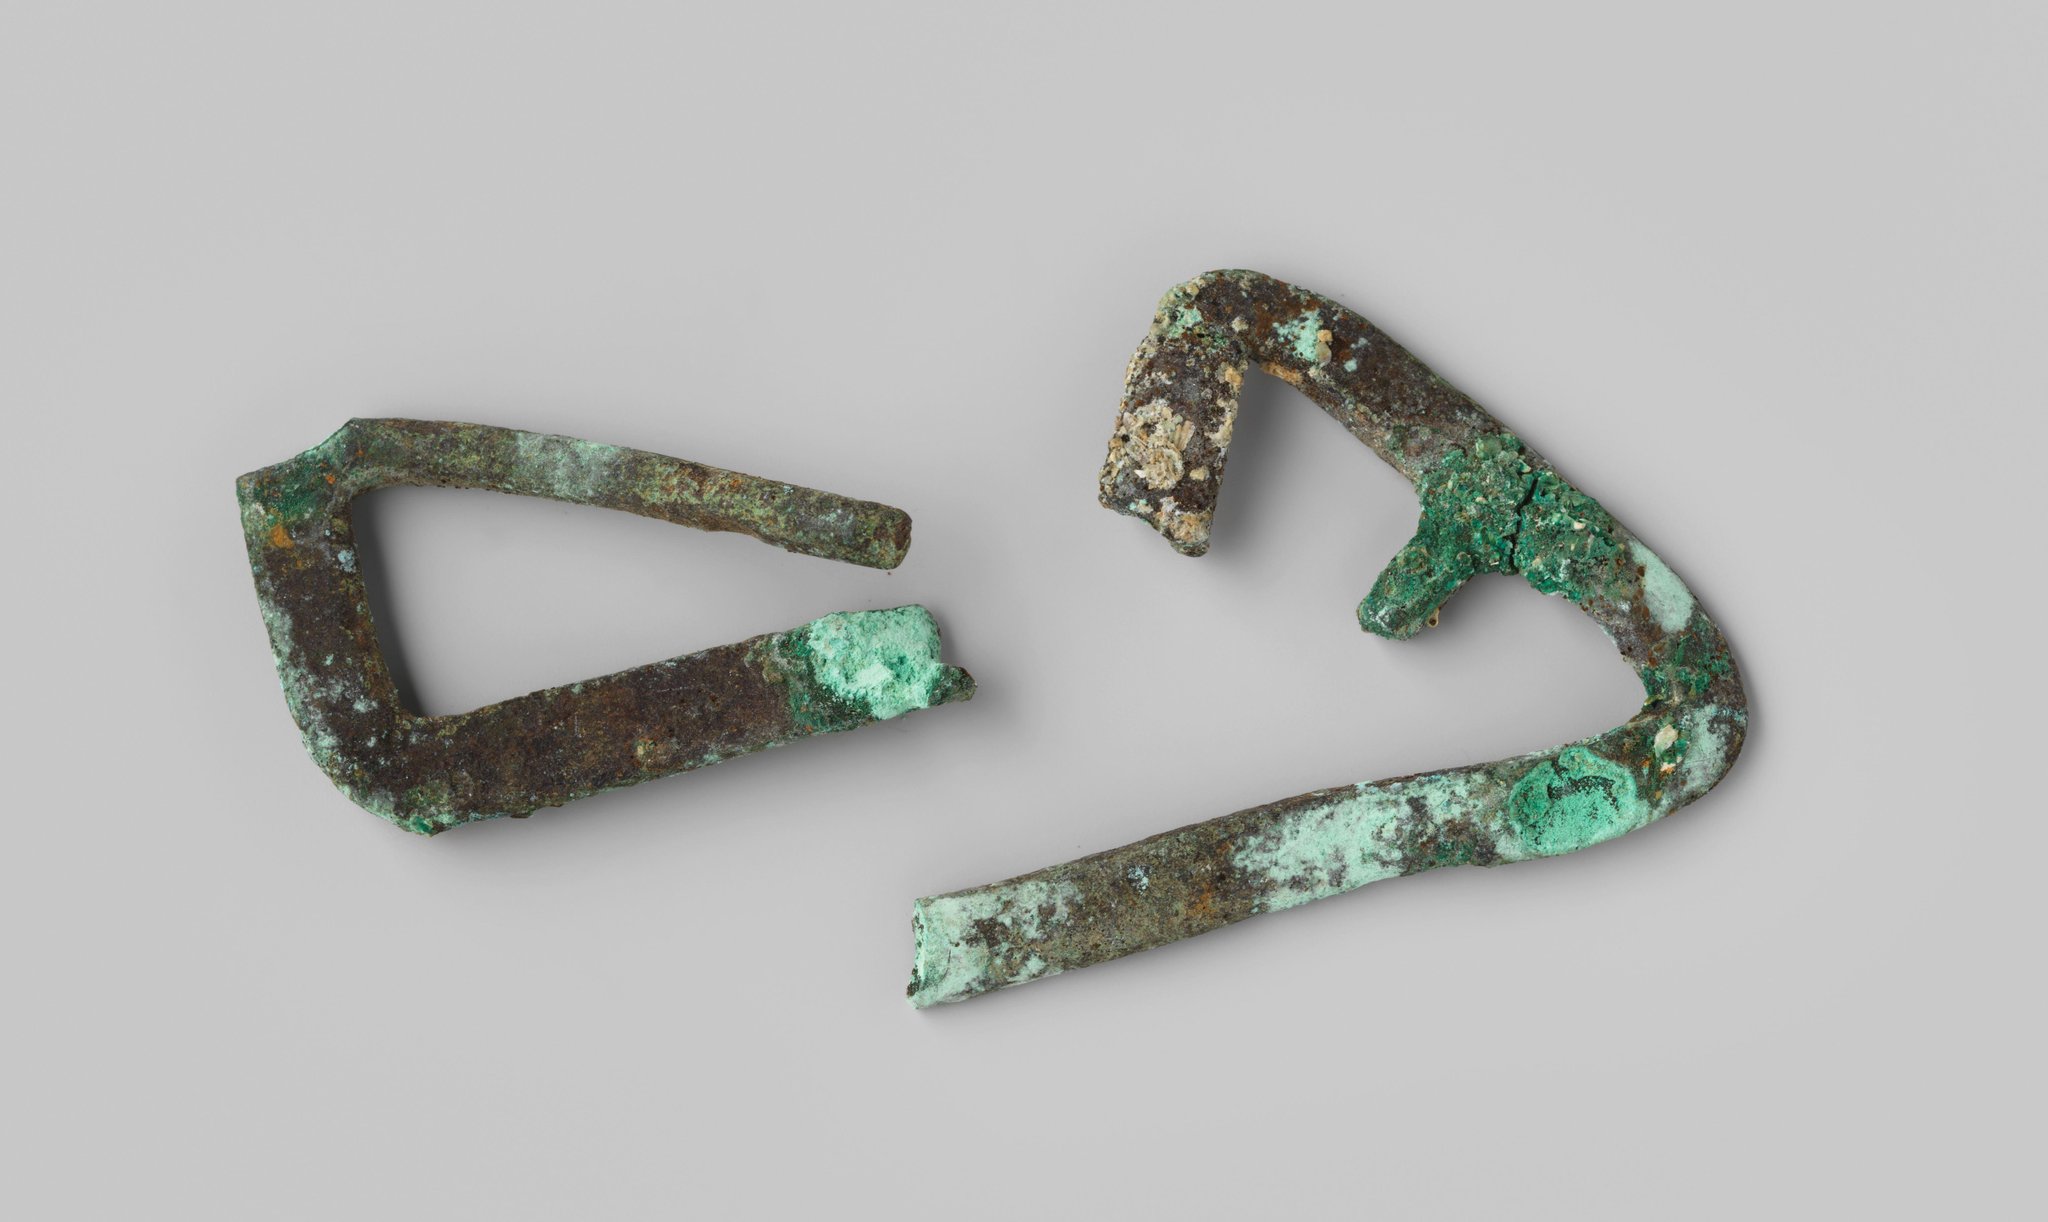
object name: belt buckle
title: Fragmenten riemgesp uit het wrak van de Oost-Indiëvaarder Hollandia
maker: Anonymous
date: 1700-1743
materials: copper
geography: netherlands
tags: verenigde oostindische compagnie, hollandia (schip), annet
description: Rectangular, fragm of ring with spindle, id. NG 1980-27H2852, belt buckle.